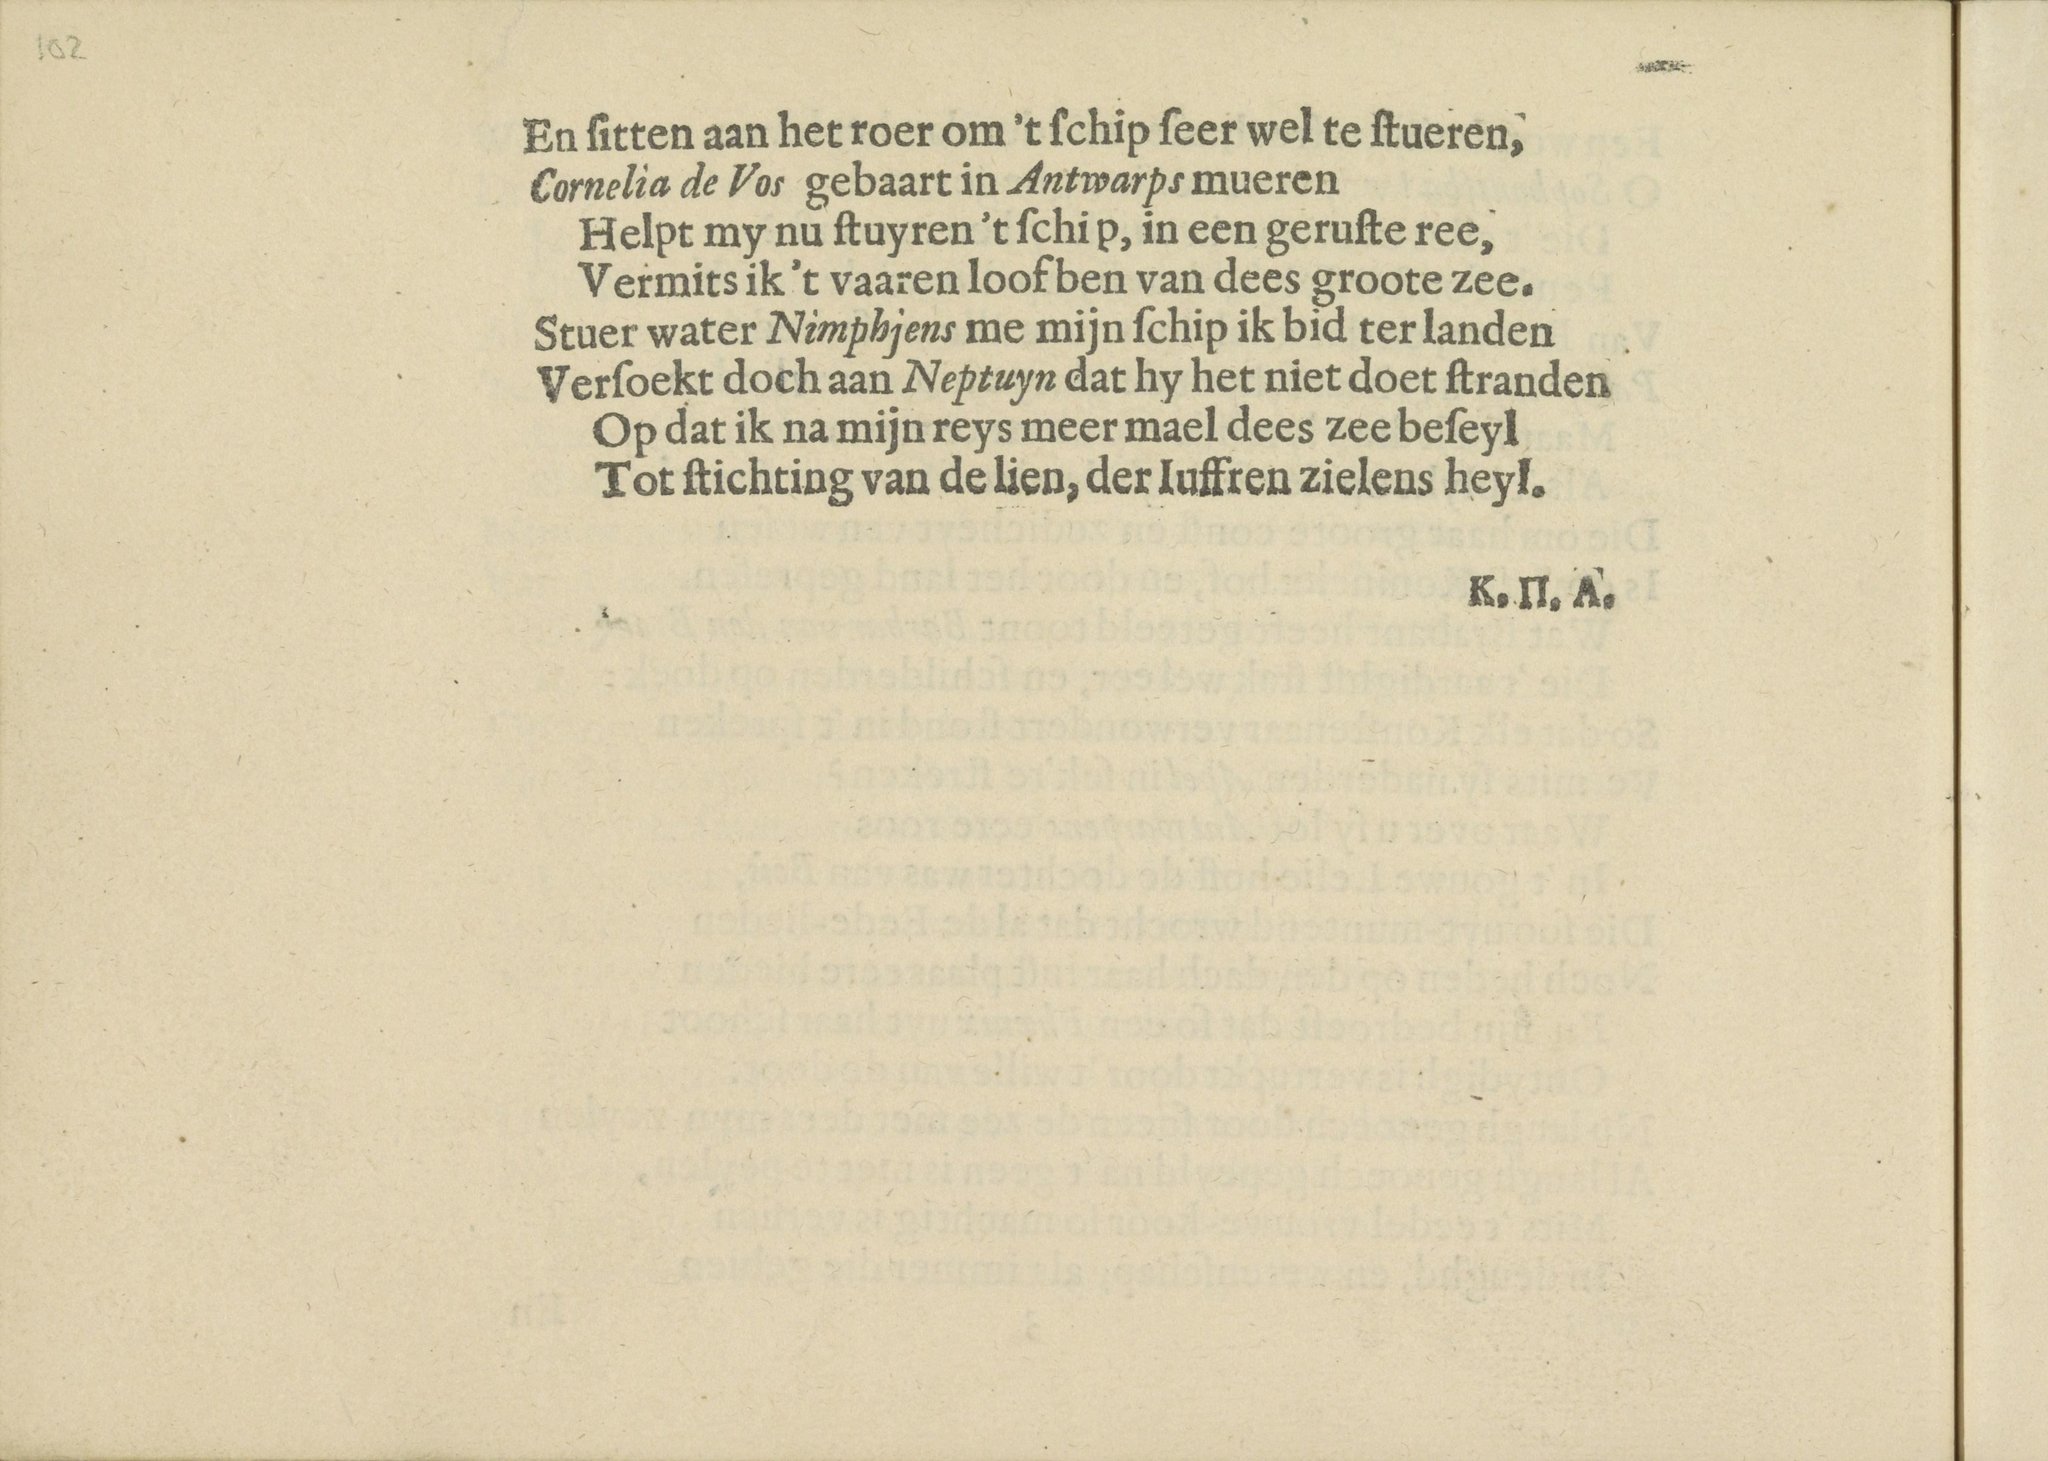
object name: album leaf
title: Nederlandstalig gedicht op de Nimfen van de Amstel, pagina 11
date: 1640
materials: paper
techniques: letterpress printing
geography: amsterdam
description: Nederlandstalig gedicht op de Nimfen van de Amstel op elf pagina's. Dit is de laatste pagina met de initialen K (Crispijn) P (in het Griekse alfabet; Passe), A (Amsterdam). Het blad maakt deel uit van een album.